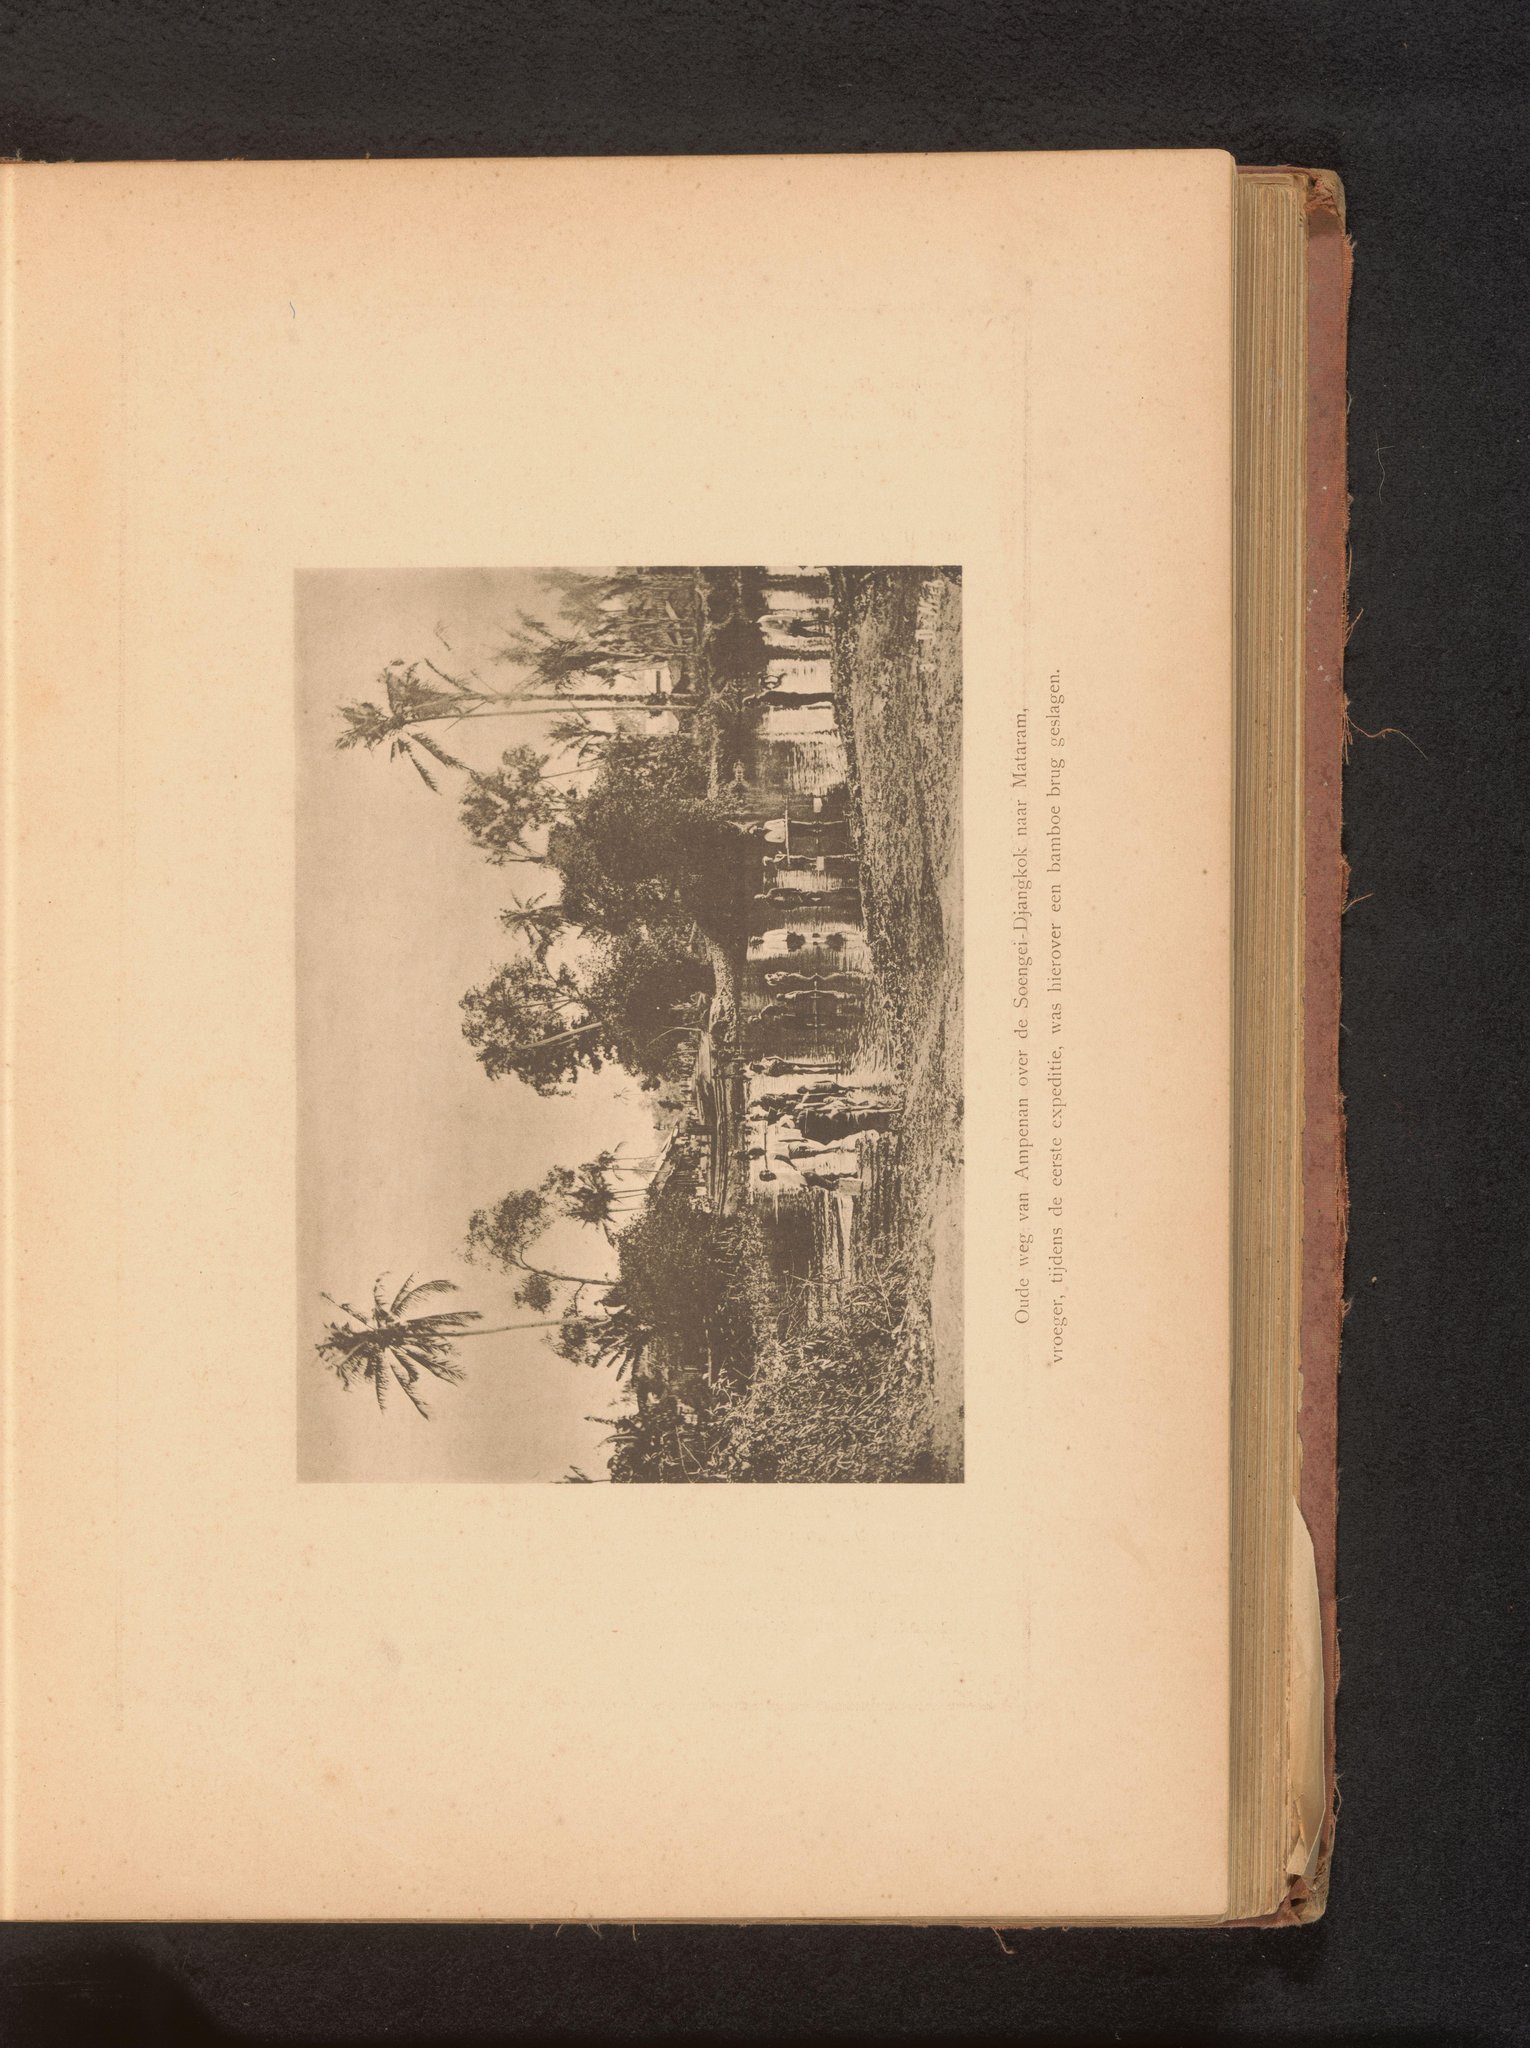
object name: page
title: Oude weg van Ampenan over de Soengei-Djangkok naar Mataram, vroeger, tijdens de eerste expeditie, was hierover een bamboe brug geslagen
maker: christiaan johan neeb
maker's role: arts, fotograaf, officier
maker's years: 1860-1925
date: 1892-1897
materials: paper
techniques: photograph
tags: river, river bank